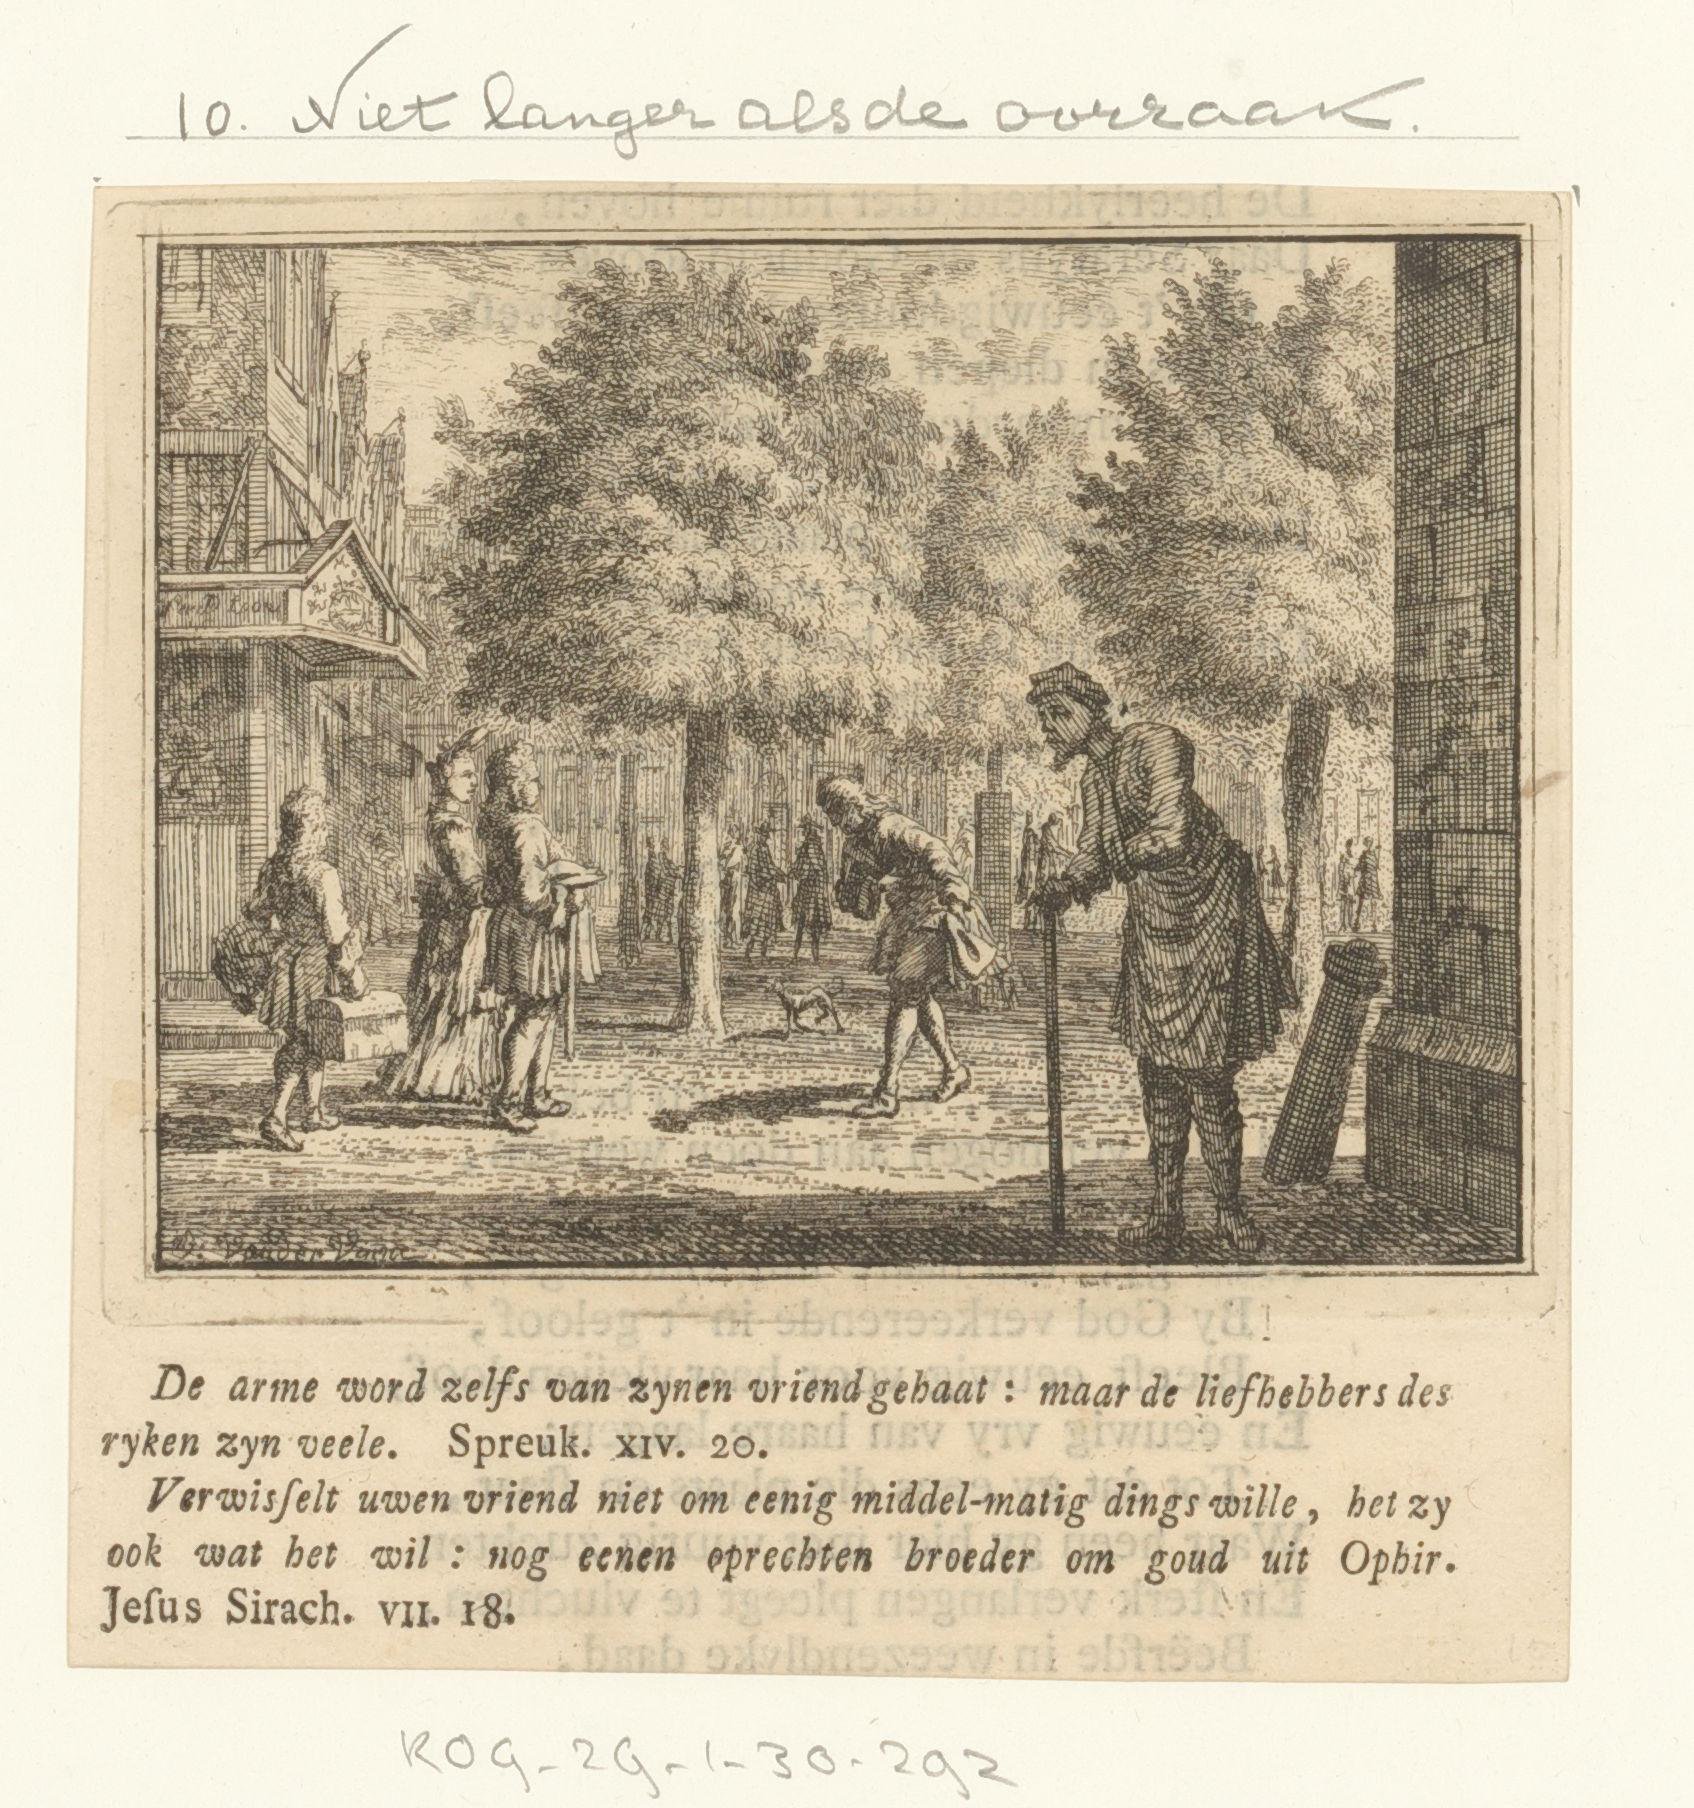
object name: print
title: Arme man met stok kijkt naar rijke mensen op een plein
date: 1758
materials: paper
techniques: etching, letterpress printing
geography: haarlem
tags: walking-stick, staff, proverbs, sayings, etc., beggar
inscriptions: stamp, collector's mark: Lugt 1641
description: Embleem bij het motto: Niet langer als de Oorzaak. Onderaan een zevenregelige tekst in het Nederlands. Onderwerpsrubrieken binnen de Atlas Zeden en Gewoonten: Zeden en Gewoonten in engeren zin. Volksleven. Zinnebeeldige voorstellingen uit het volkleven op serieprenten. Maanden en diversen (allegorieën).